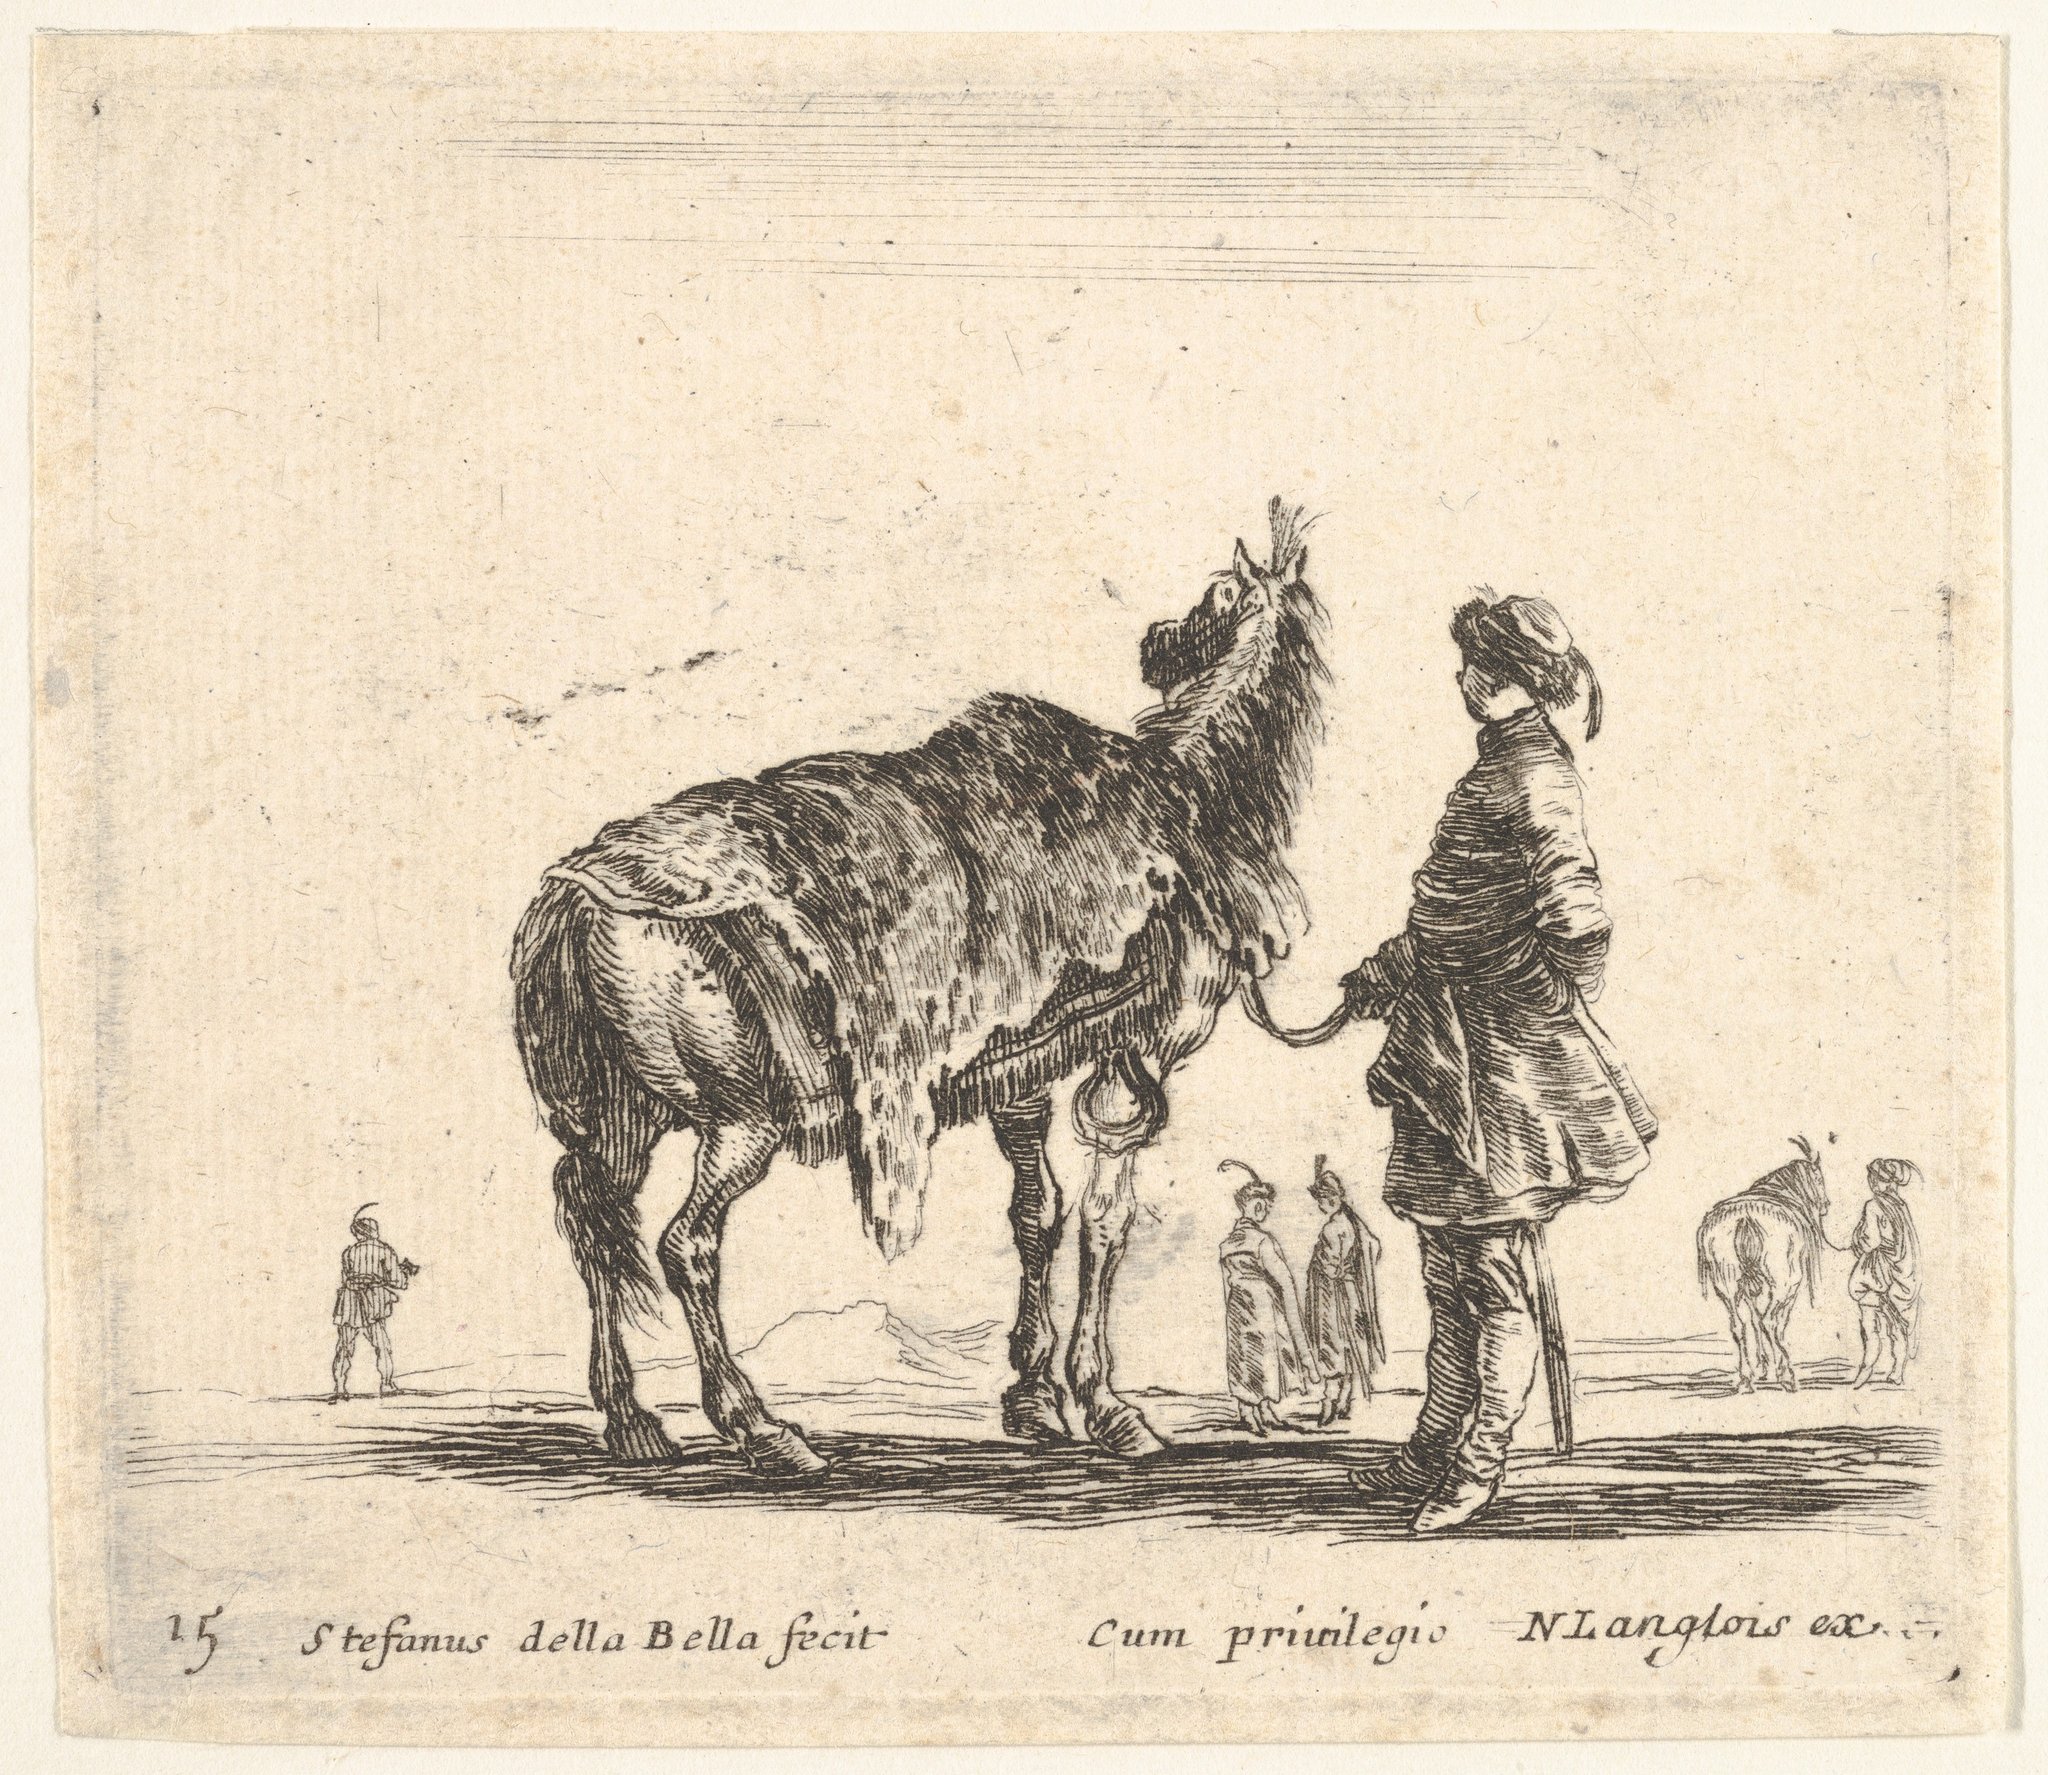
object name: print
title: Plate 15: a Polish nobleman, facing away, holding his horse covered in leopard skin, four men and a horse in background, from "Diversi Capricci"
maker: stefano della bella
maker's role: artist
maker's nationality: italian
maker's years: 1610-1664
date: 1644-1647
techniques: etching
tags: men,horses